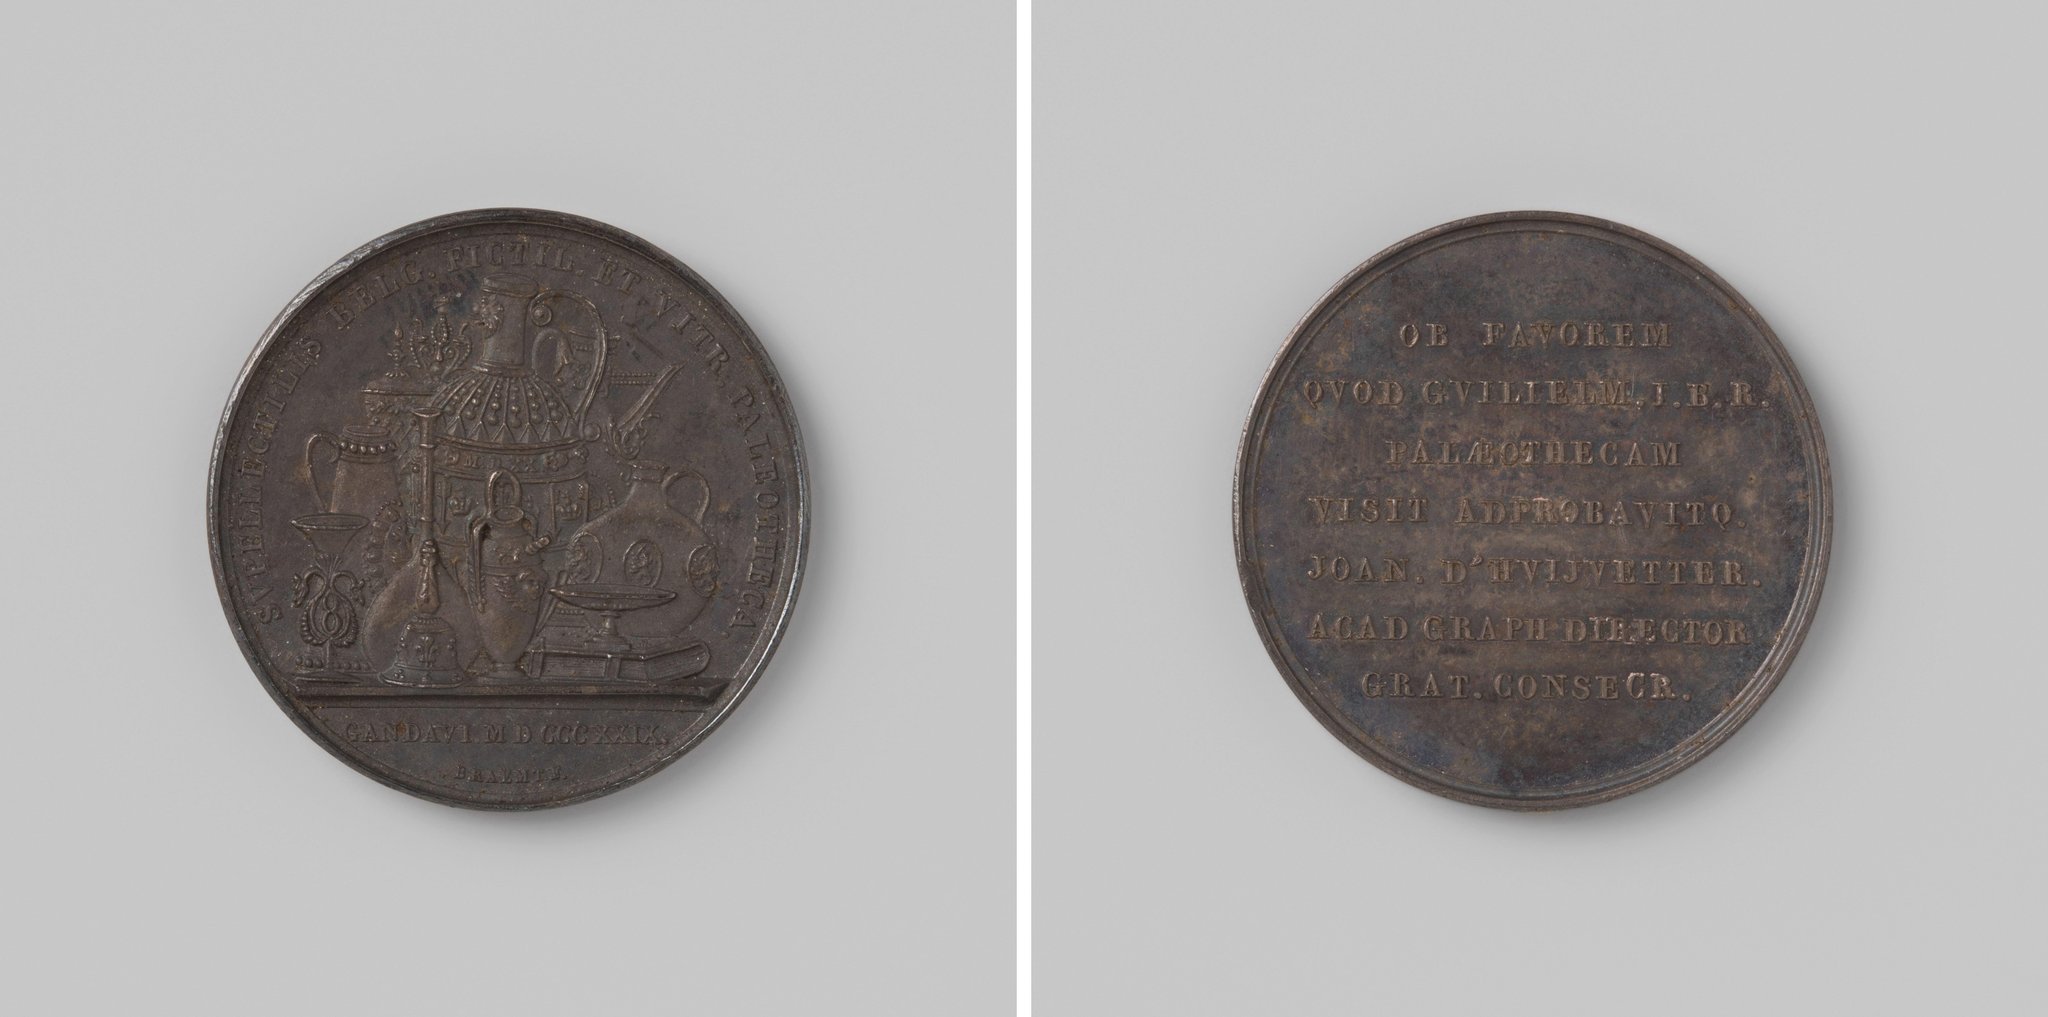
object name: history medal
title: Bezoek van Willem I Frederik, koning der Nederlanden aan het oudheidkundig kabinet van J. d'Huyvetter te Gent, penning geslagen op last van d'Huyvetter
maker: joseph pierre braemt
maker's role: print maker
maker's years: 1796-1864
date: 1829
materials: silver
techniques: striking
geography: brussels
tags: the hague, berlin, william i of the netherlands, ghent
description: Zilveren penning. Voorzijde: verzameling antiquiteiten binnen omschrift; afsnede: opschrift. Keerzijde: opschrift